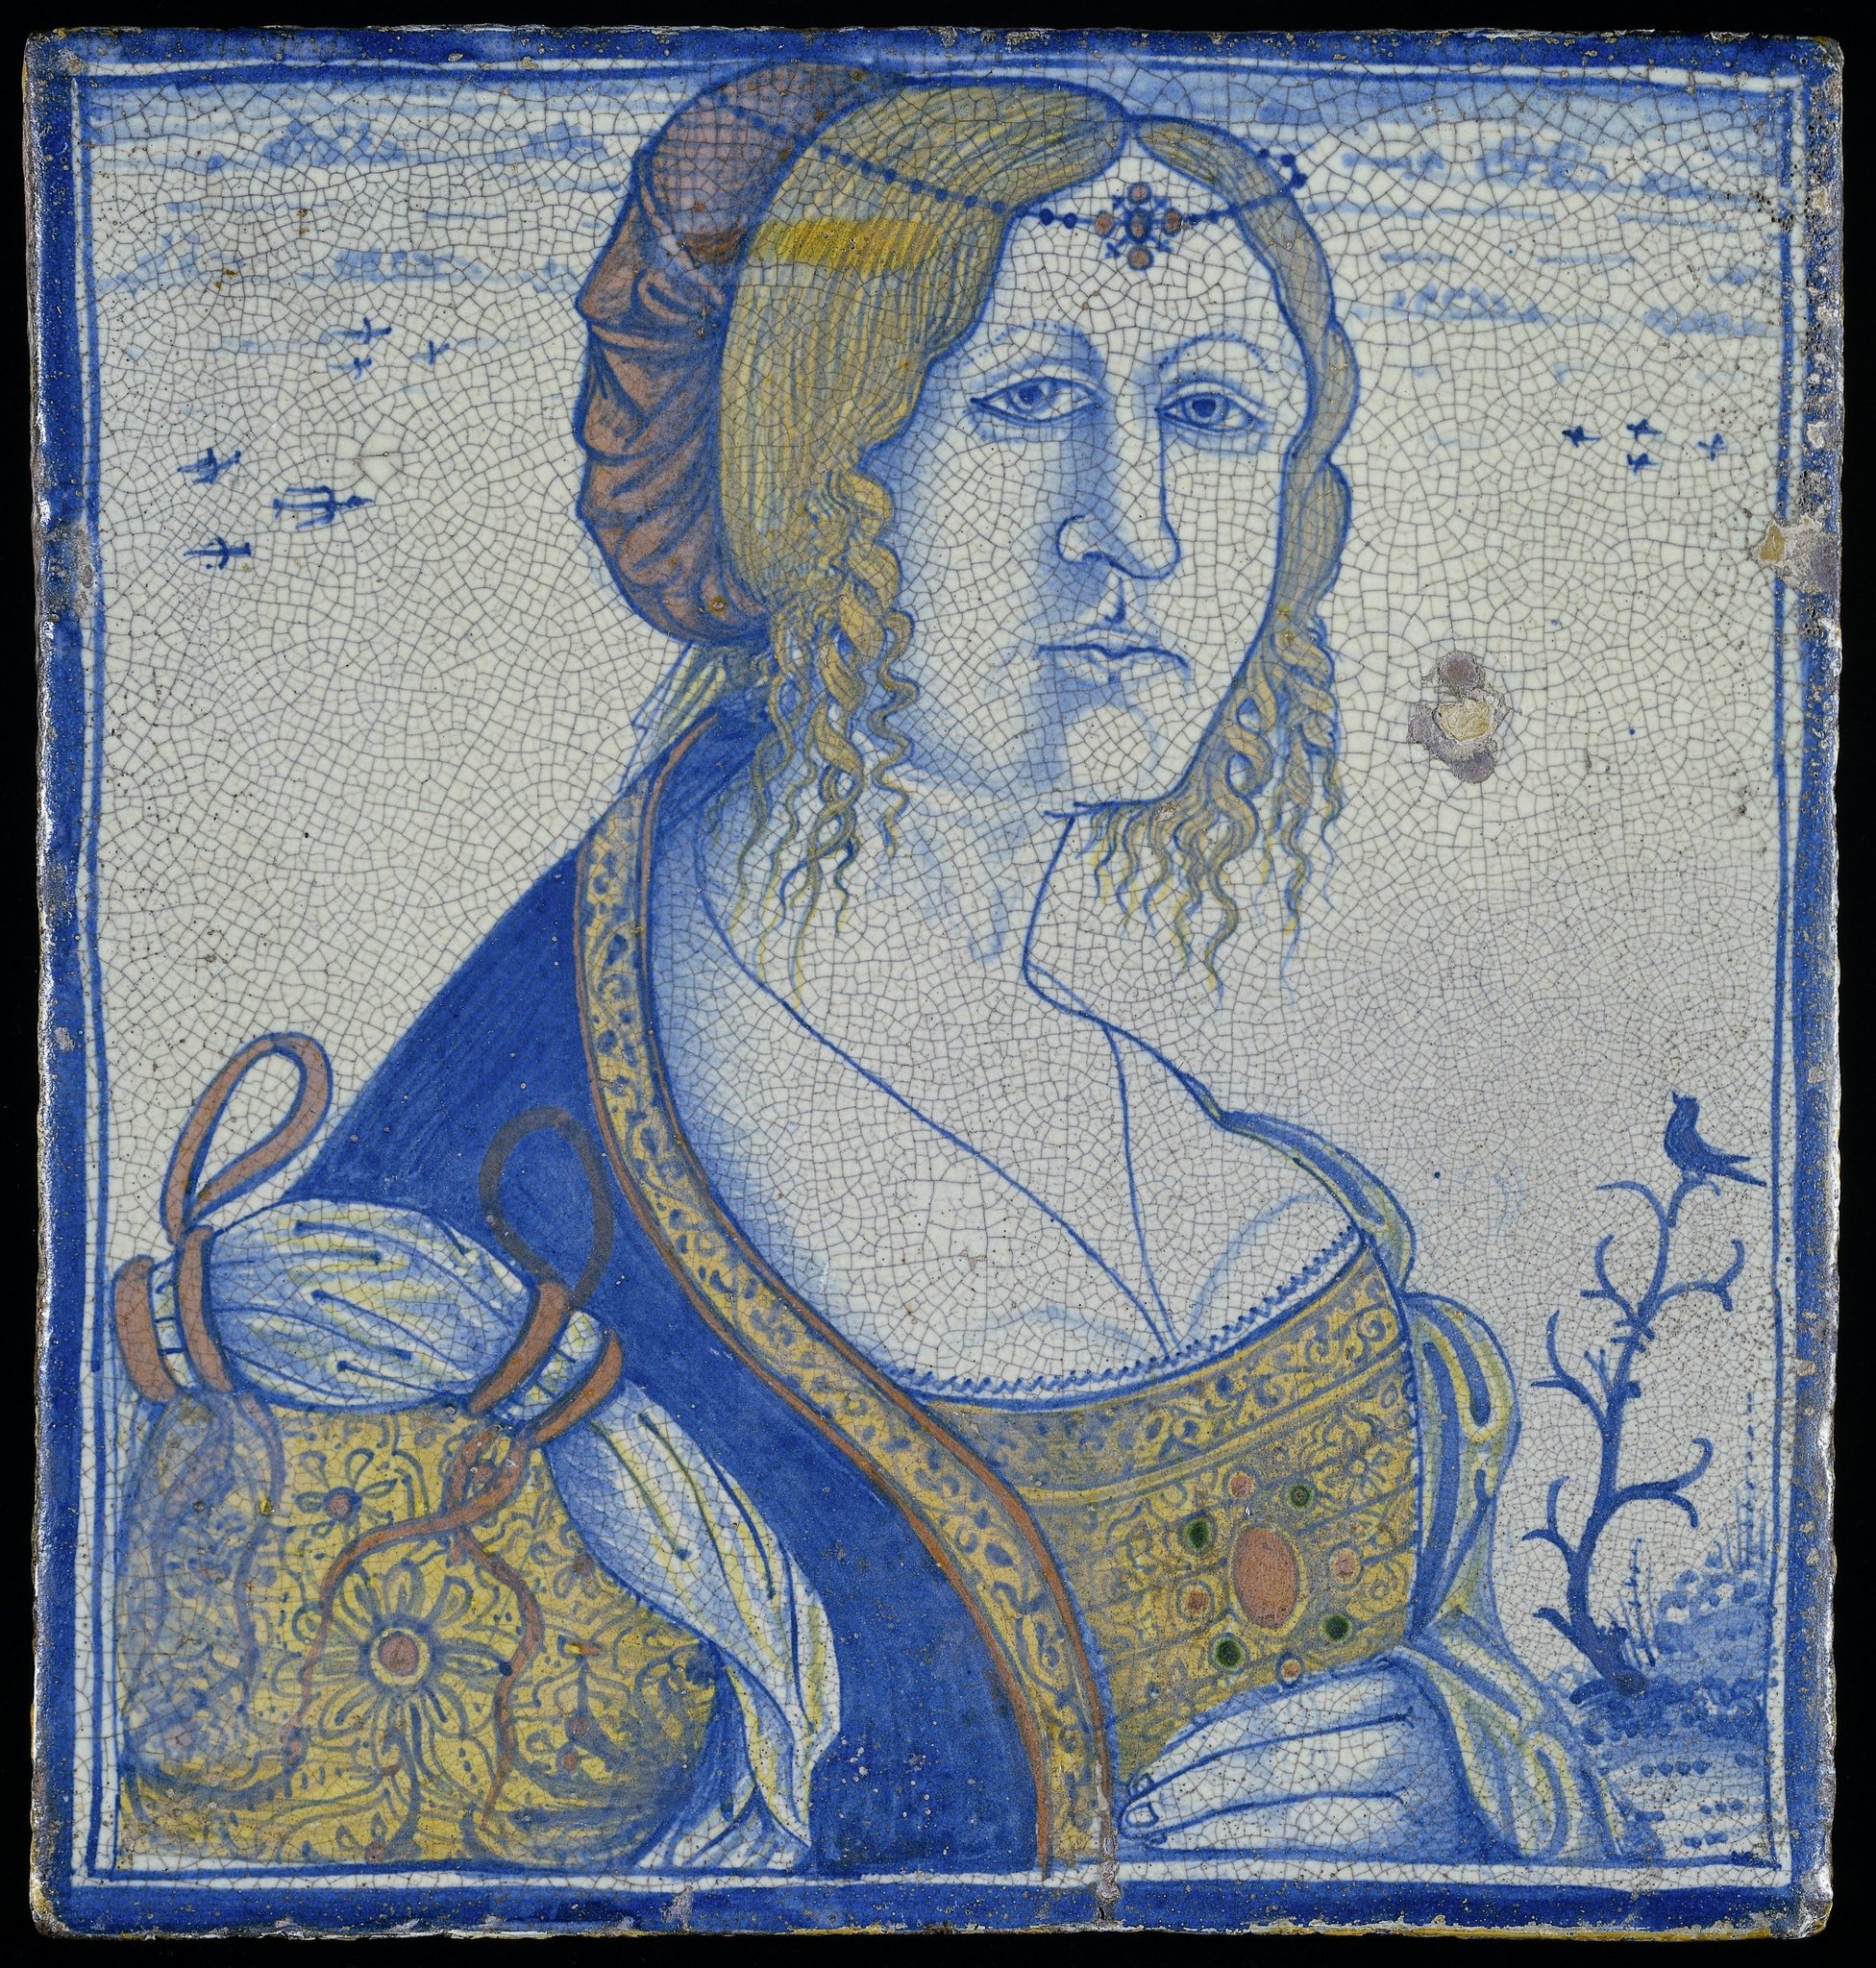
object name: tile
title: Tegel met het portret van een vrouw, oorspronkelijk gebruikt als gevelsteen in het huis Wijnhaven 16 te Delft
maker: leonardo da vinci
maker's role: artist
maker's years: 1452-1519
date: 1535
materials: earthenware, glaze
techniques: maiolica, painted, polychromy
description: Tile with a portrait of a woman. Maiolica. Italy, c. 1510 - 1520. Originally used as a tablet on the house at 16 Wijnhaven in Delft.